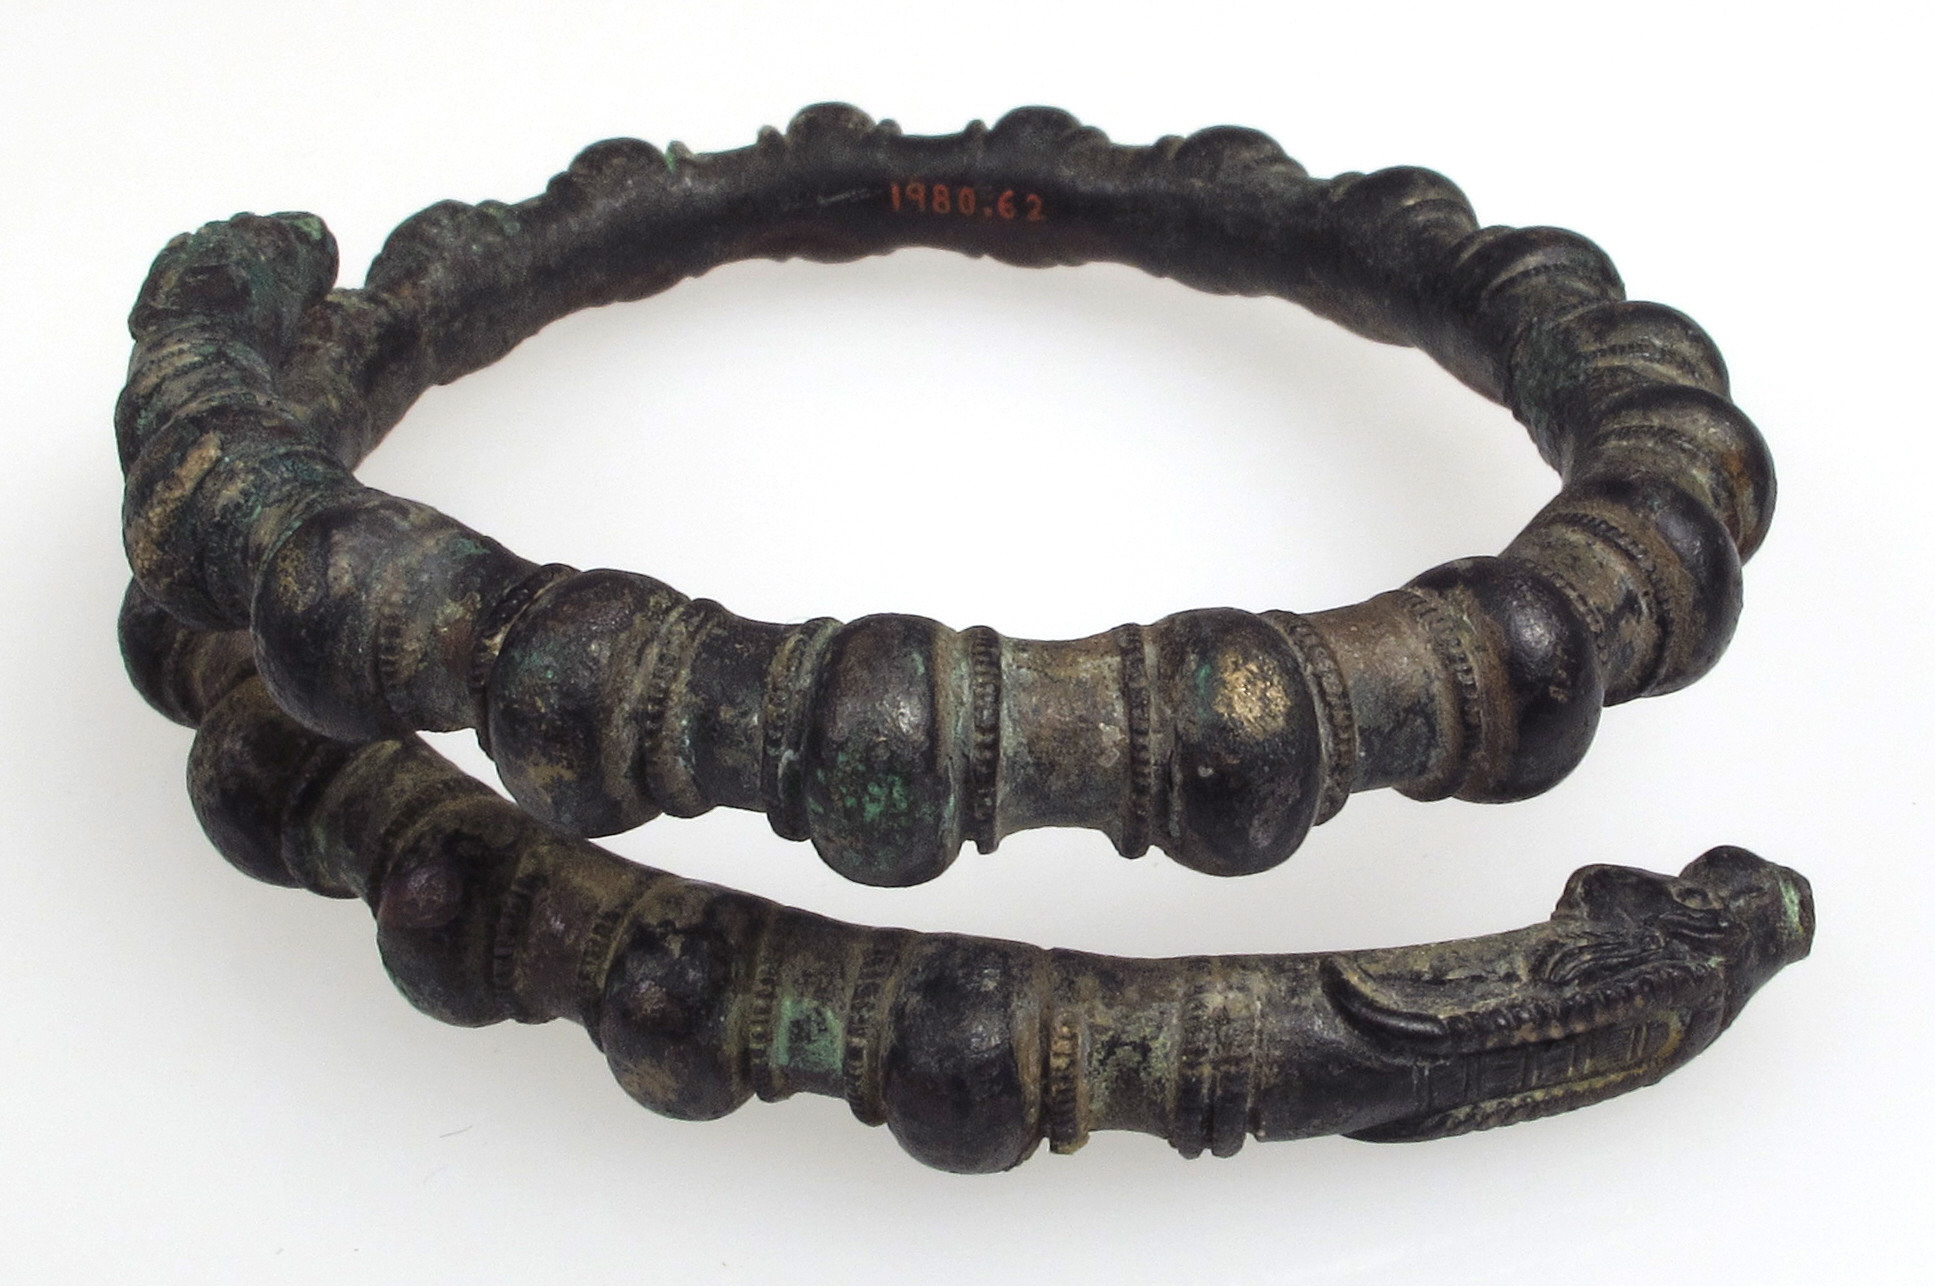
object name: armlet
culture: celtic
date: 400 BCE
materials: bronze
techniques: casting